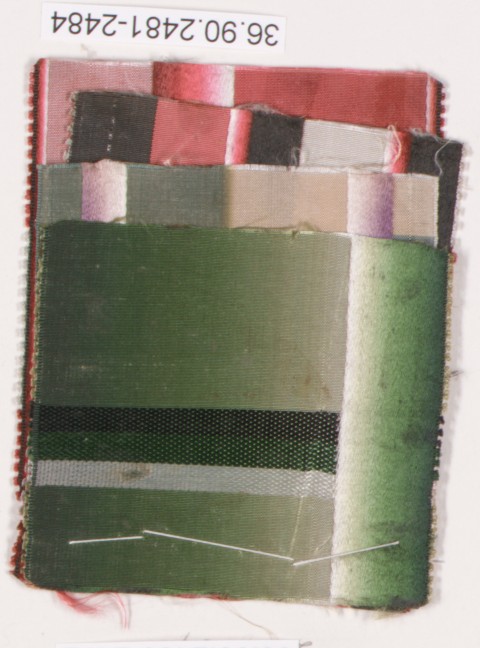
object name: ribbon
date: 1801-1900